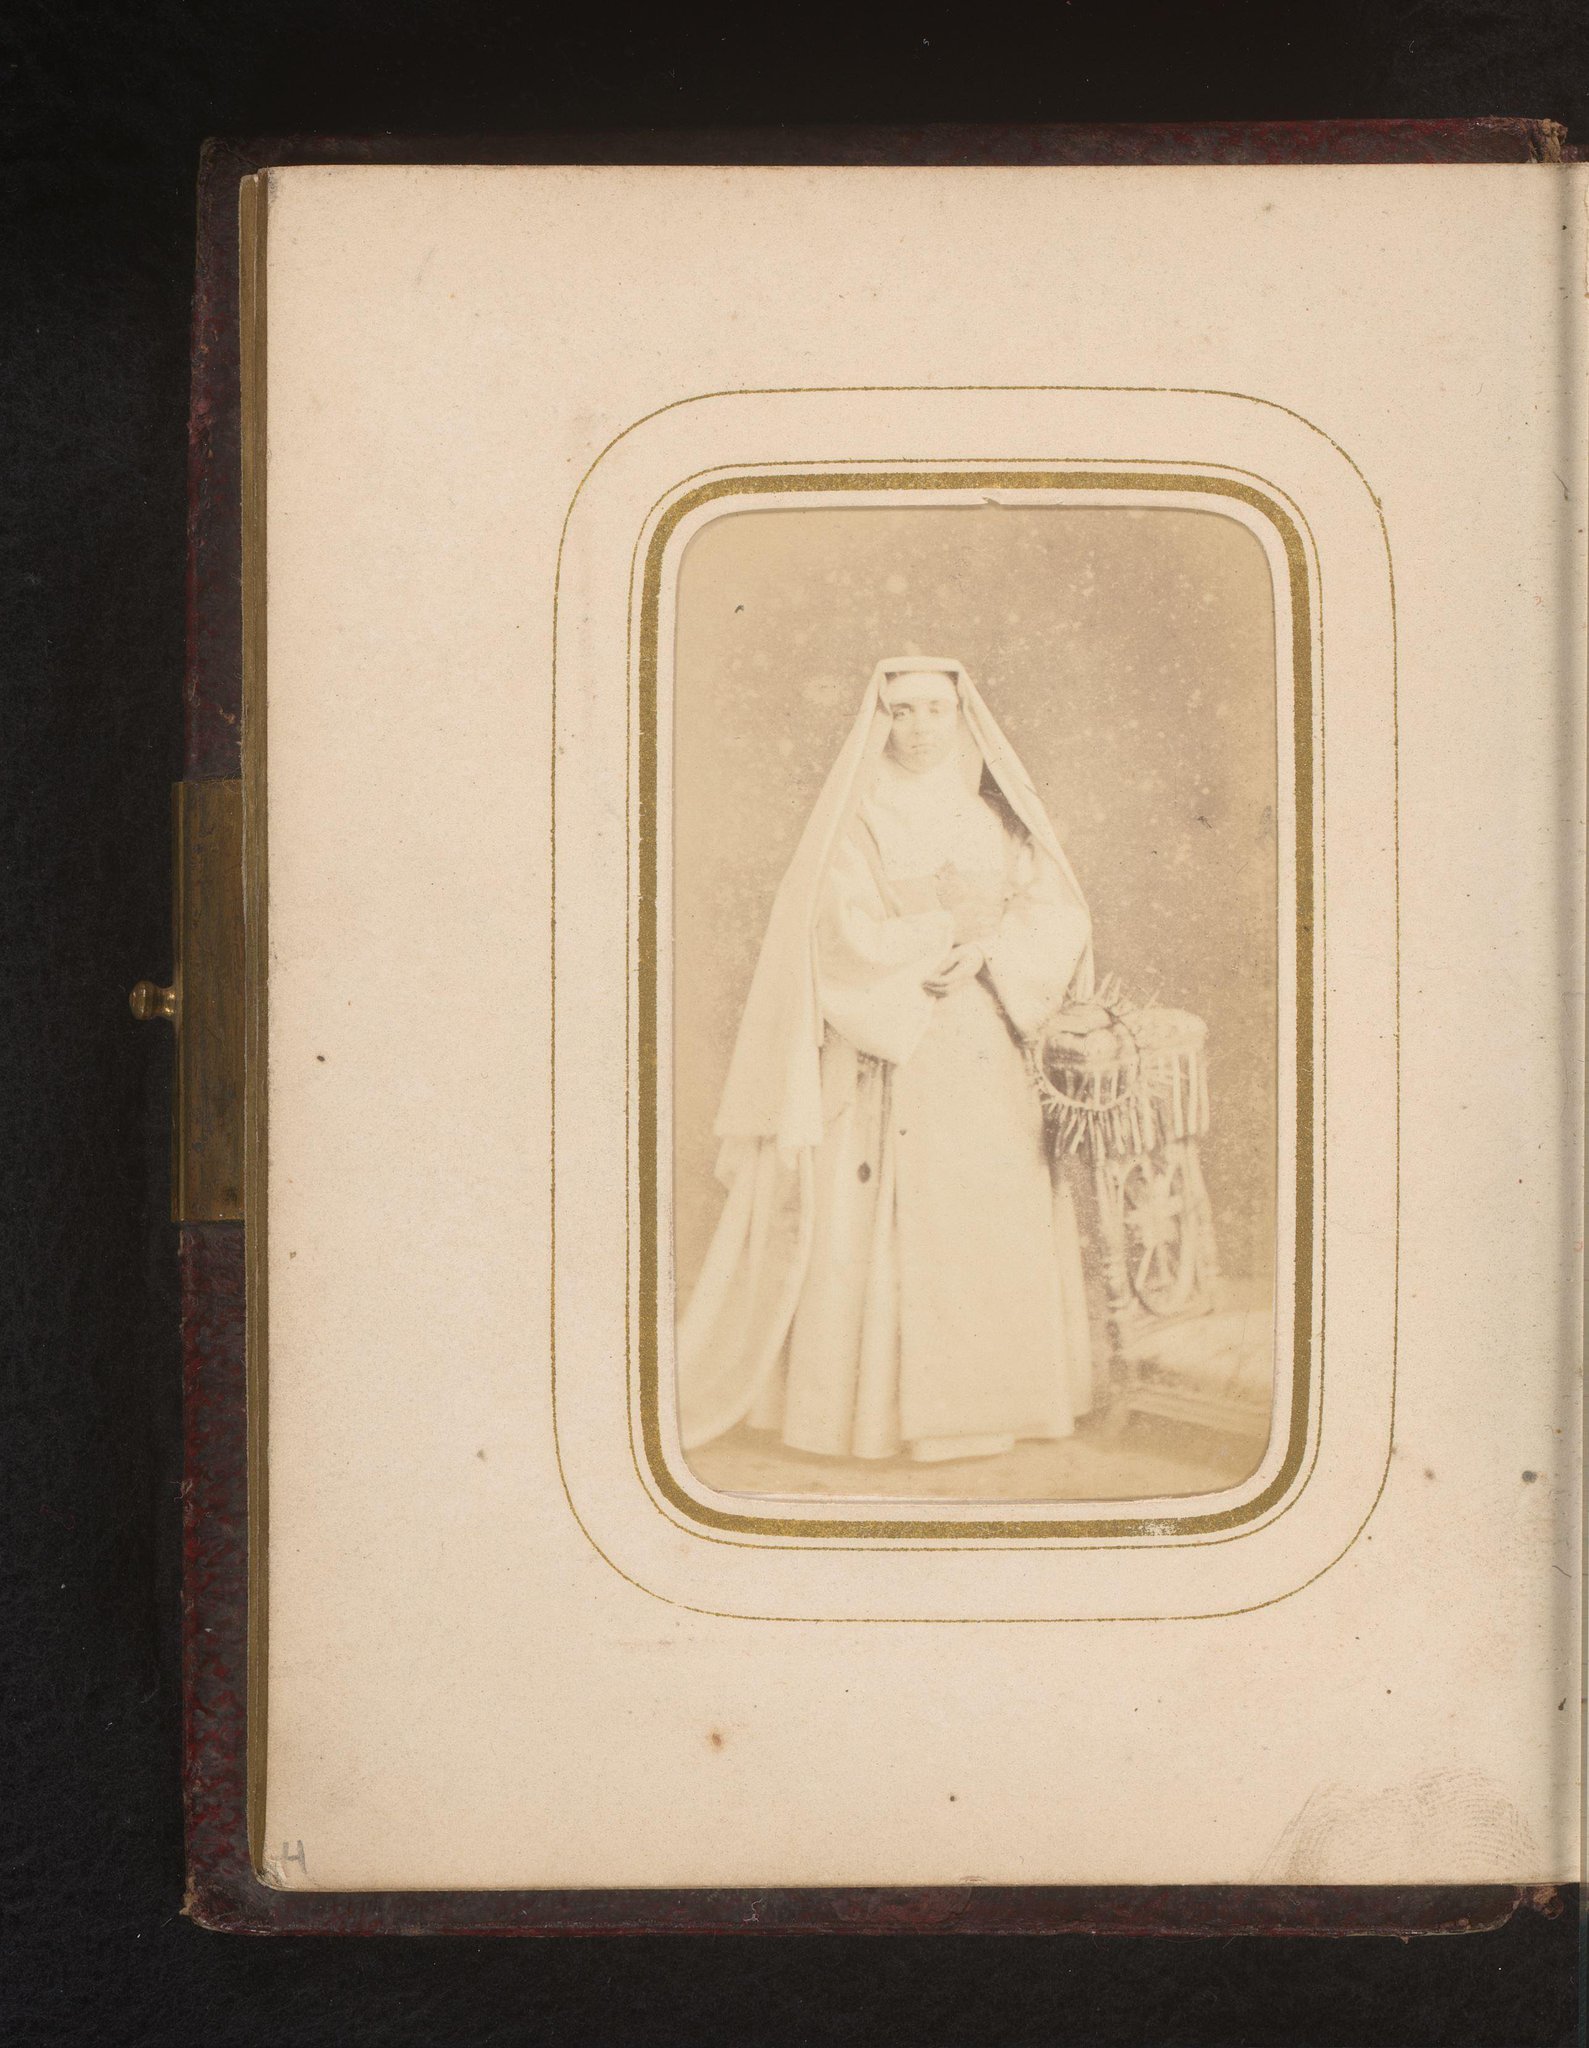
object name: album leaf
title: Portret van een non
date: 1860-1900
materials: cardboard, photographic support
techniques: albumen print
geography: paris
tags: nun(s)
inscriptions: inscription: ‘Maison/ Mayer & Pierson/ Photographes de S.M. L'empereur/ Boulevart des Capucines, 3/ Paris’